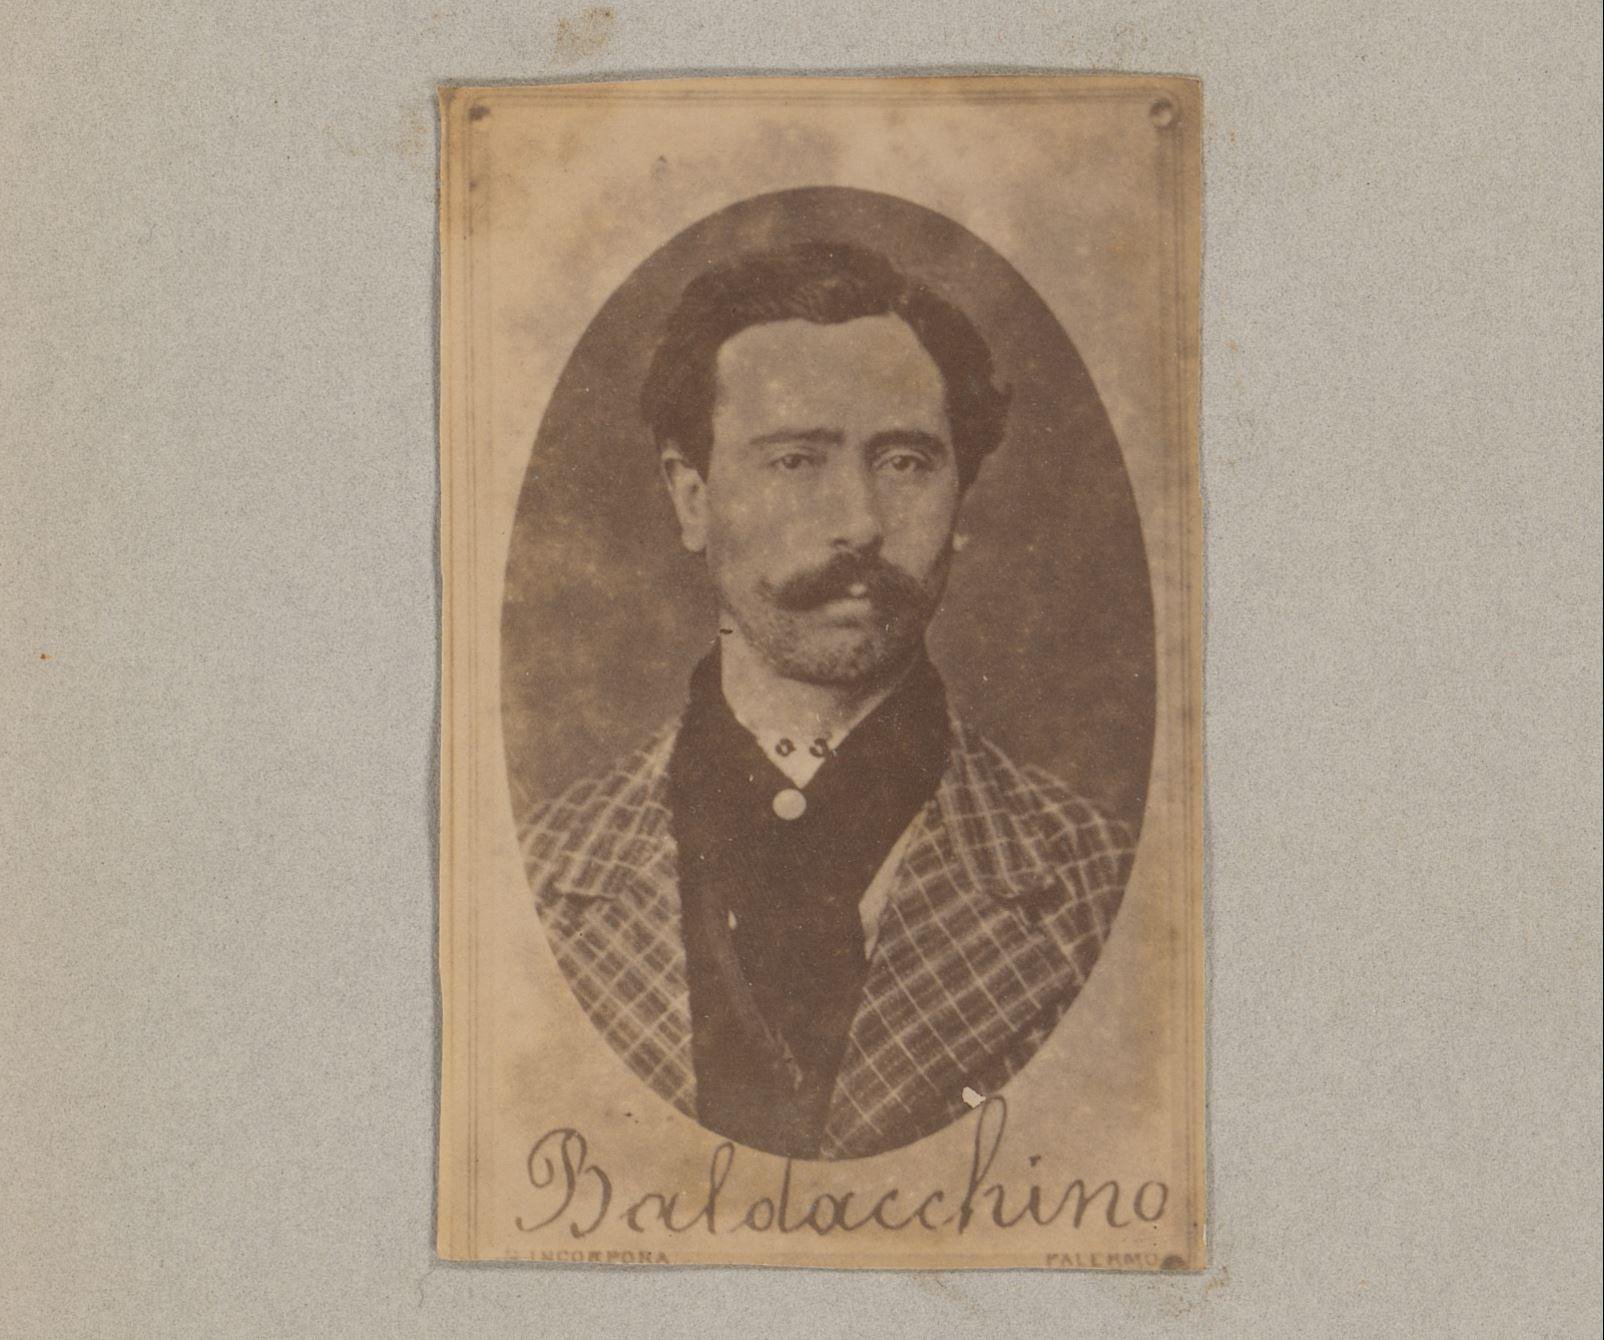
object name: reproduction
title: Fotoreproductie van 'Baldacchino', Siciliaanse brigard door G. Incorpora, volgens methode Monckhoven (8 sec.)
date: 1887-1888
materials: paper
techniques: albumen print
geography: palermo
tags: adult man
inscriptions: inscription: ‘6 Brigards de Sicilie capturés en 1878/ exécutés en 1880 à Palerme./ (Reproductie vergr. pl. Monckhoven 8 sec.)’, inscription: ‘Baldacchino/ G. Incorpora/ Palermo’